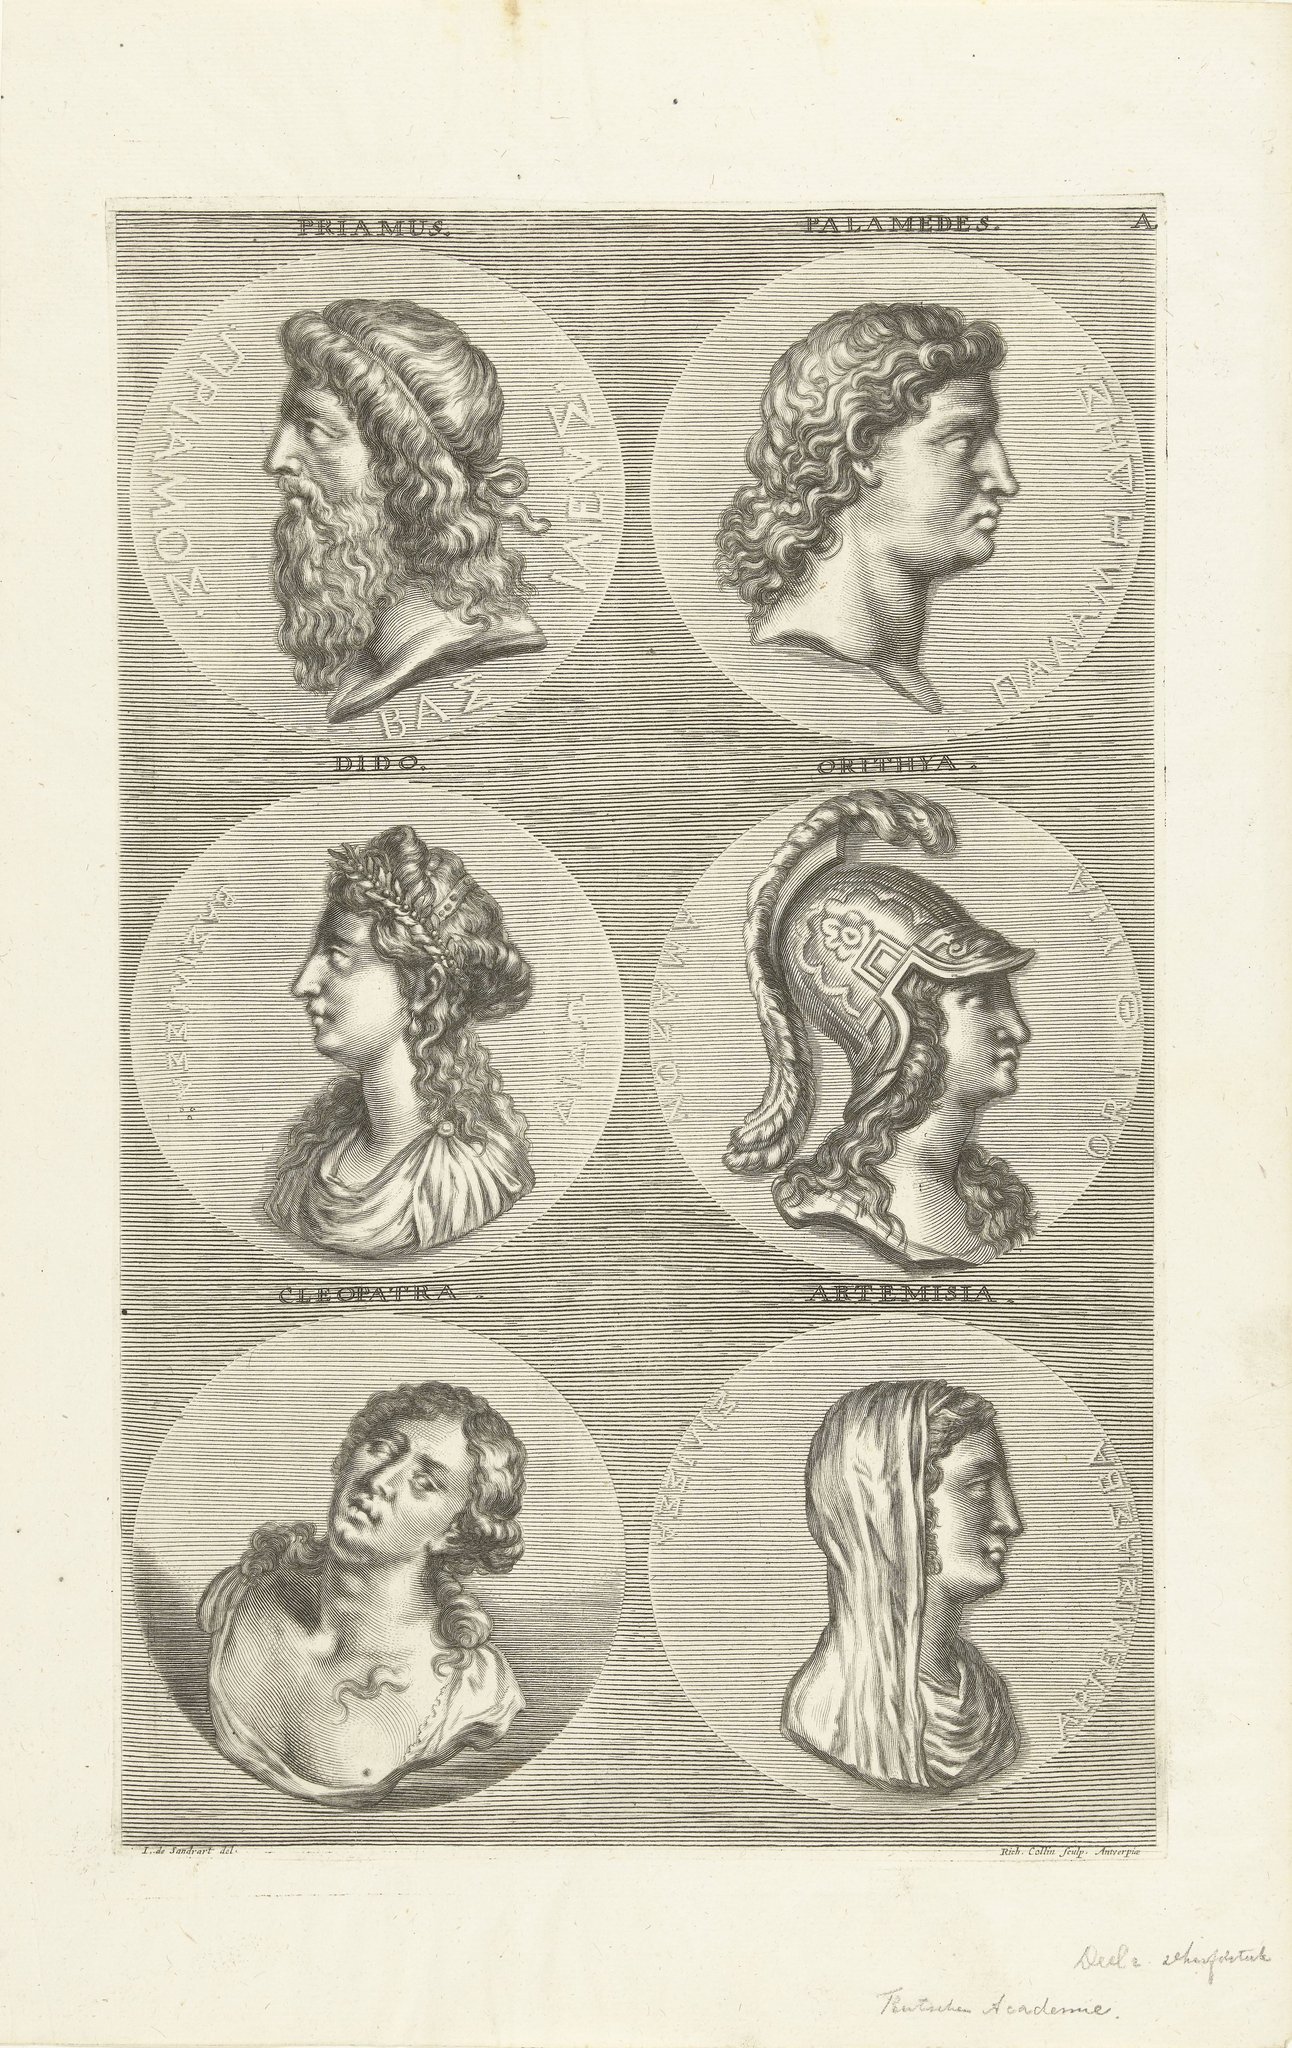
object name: print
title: Zes munten met portretten van mannen en vrouwen uit de klassieke oudheid en de mythologie: letter A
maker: richard collin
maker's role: print maker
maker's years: 1627-1697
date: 1675-1680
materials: paper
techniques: engraving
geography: antwerp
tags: coin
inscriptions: collector's mark: Lugt 2228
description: Illustratie voor: Joachim von Sandrart, L'Academia Todesca della Architectura Scultura e Pittura oder Teutsche Academie der Edlen Bau-, Bild- und Mahlerey-Künste. Nürnberg: 1675-1680.